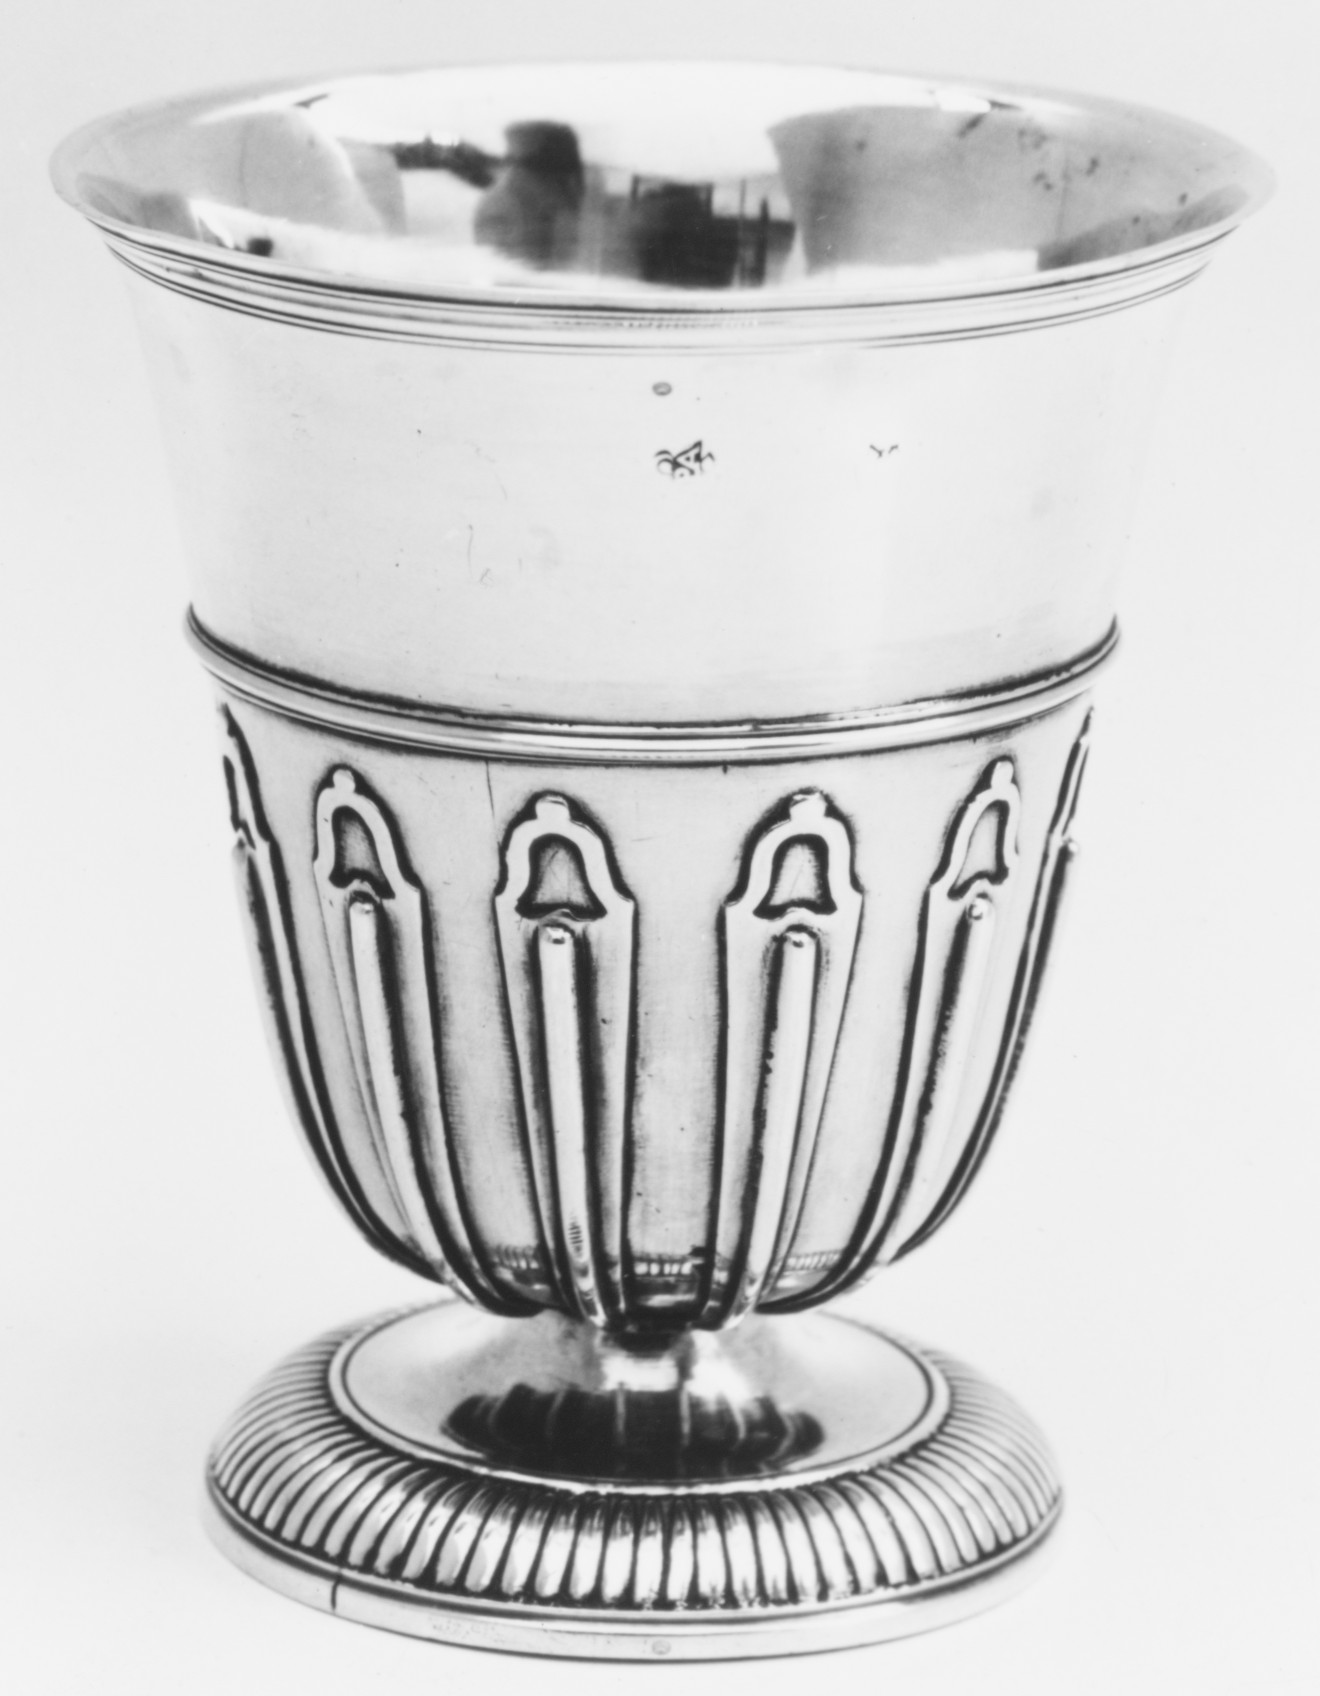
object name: beaker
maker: i.p.a.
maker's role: maker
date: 1701-1750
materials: silver